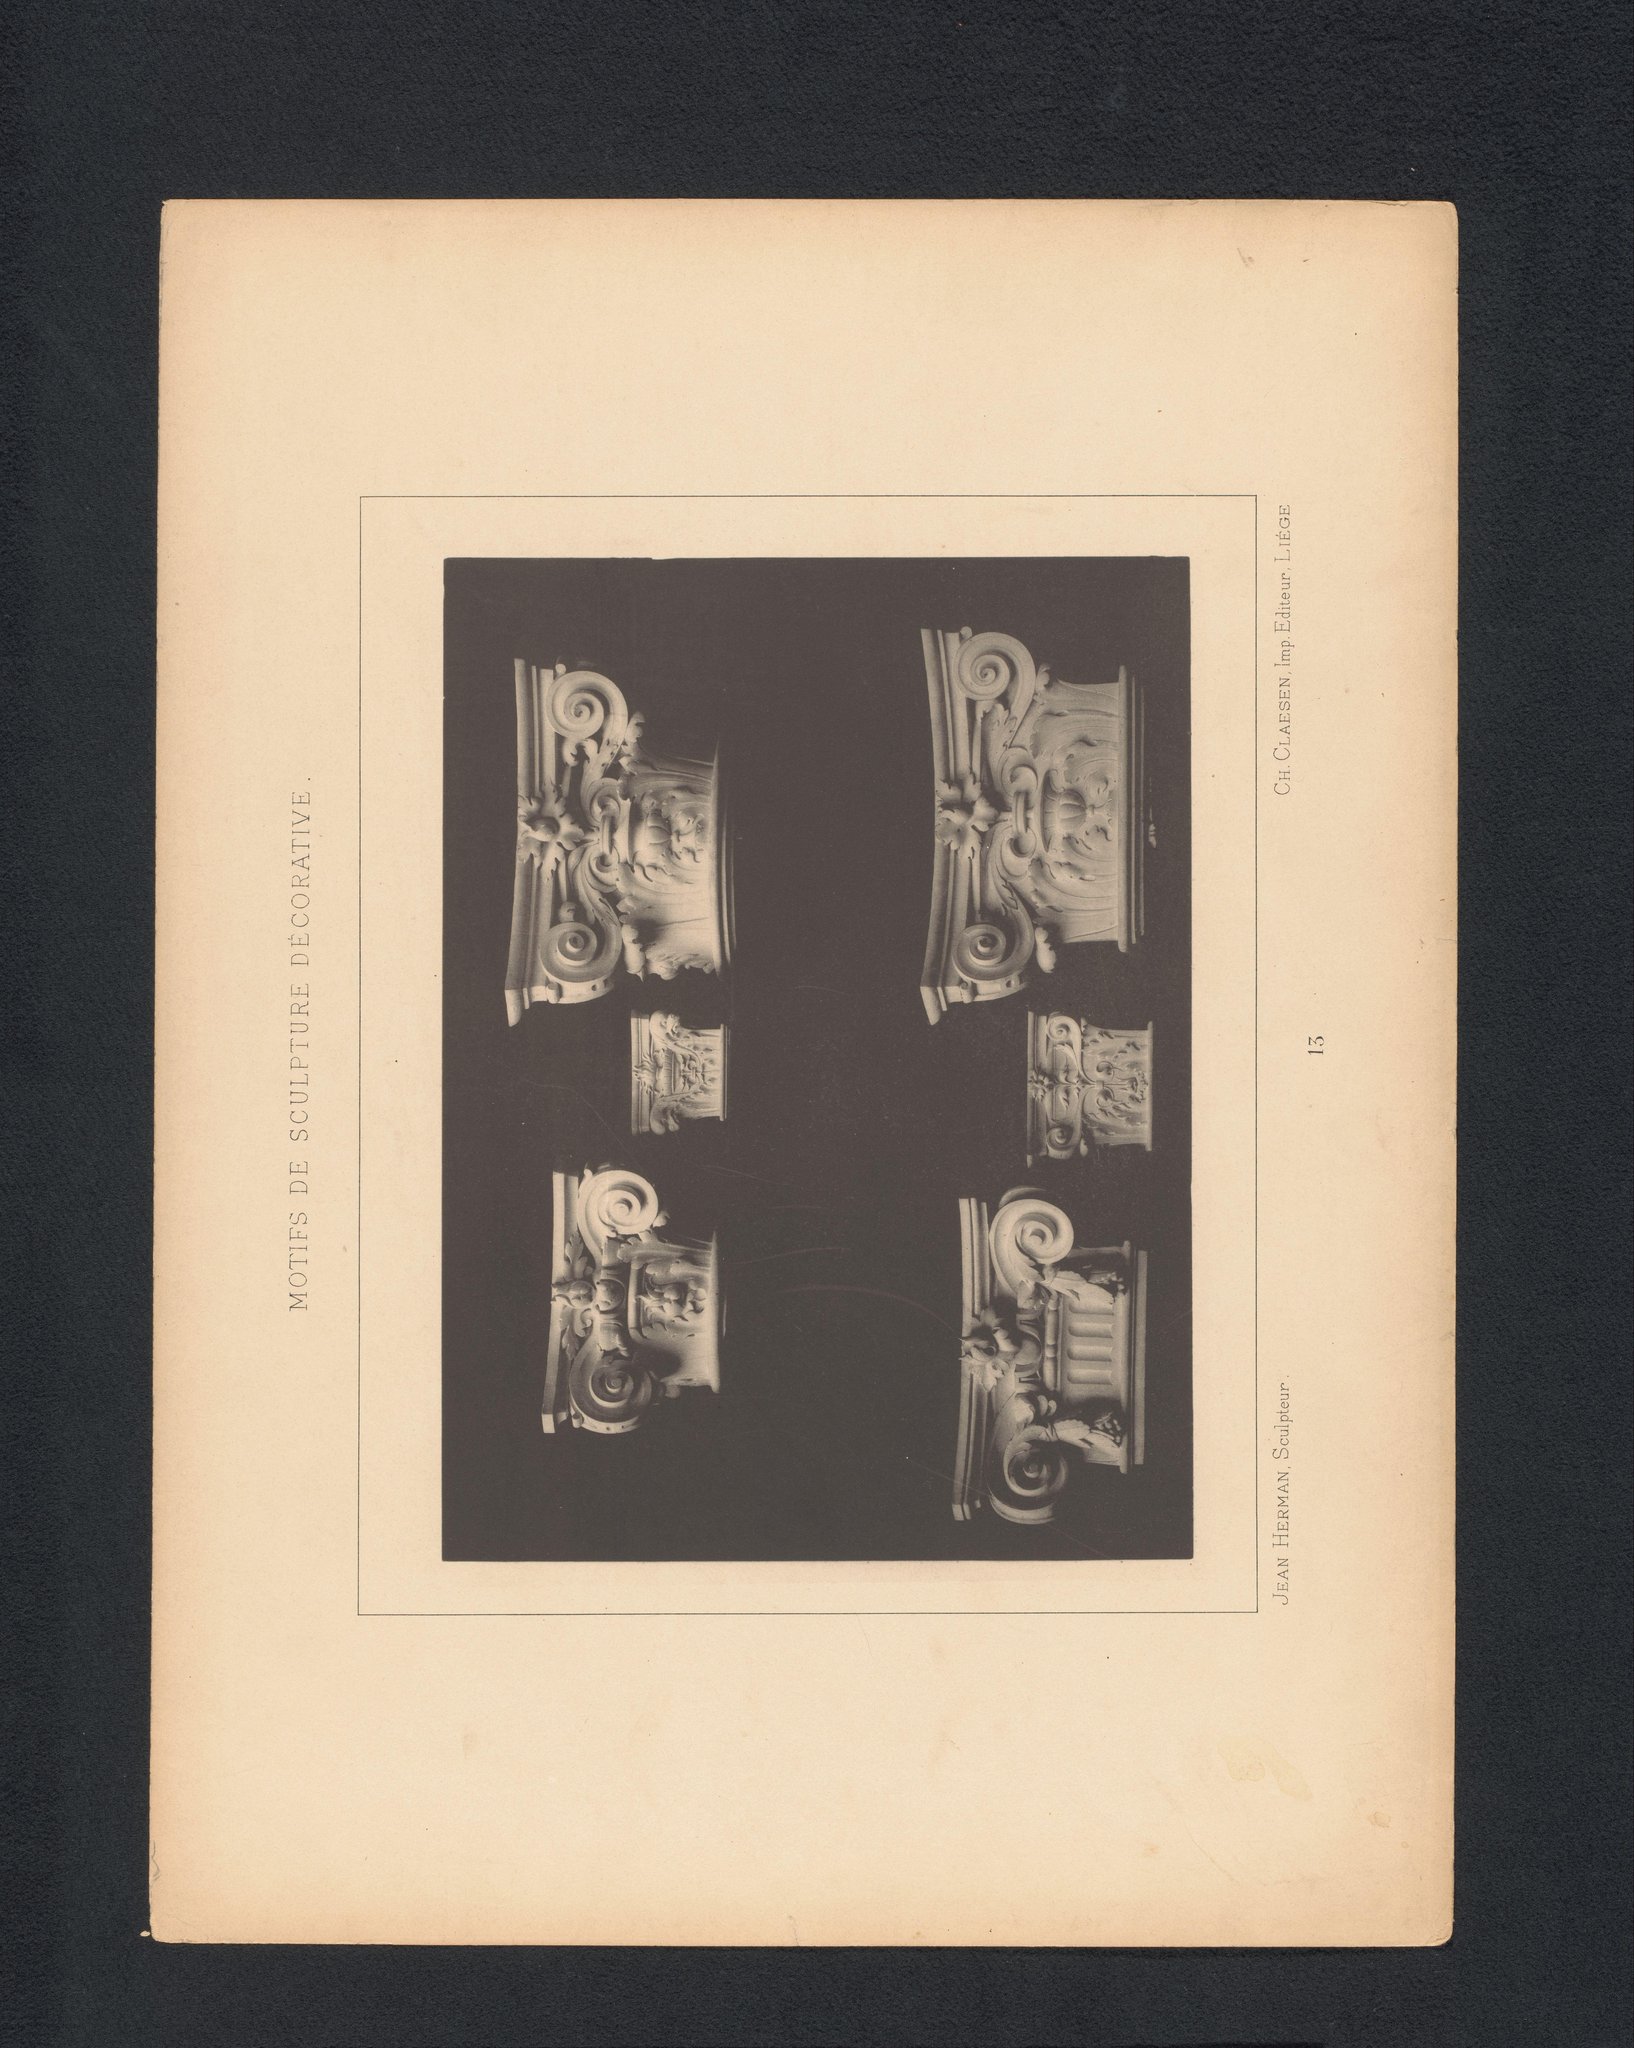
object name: photomechanical print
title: Motifs de sculpture décorative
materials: paper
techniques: photograph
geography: liège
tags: capital (~ column, pillar)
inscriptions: inscription: ‘Jean Herman, Sculpteur.’, number: ‘13’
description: Deze prent maakt deel uit van een omslag met 28 prenten en een titelblad.